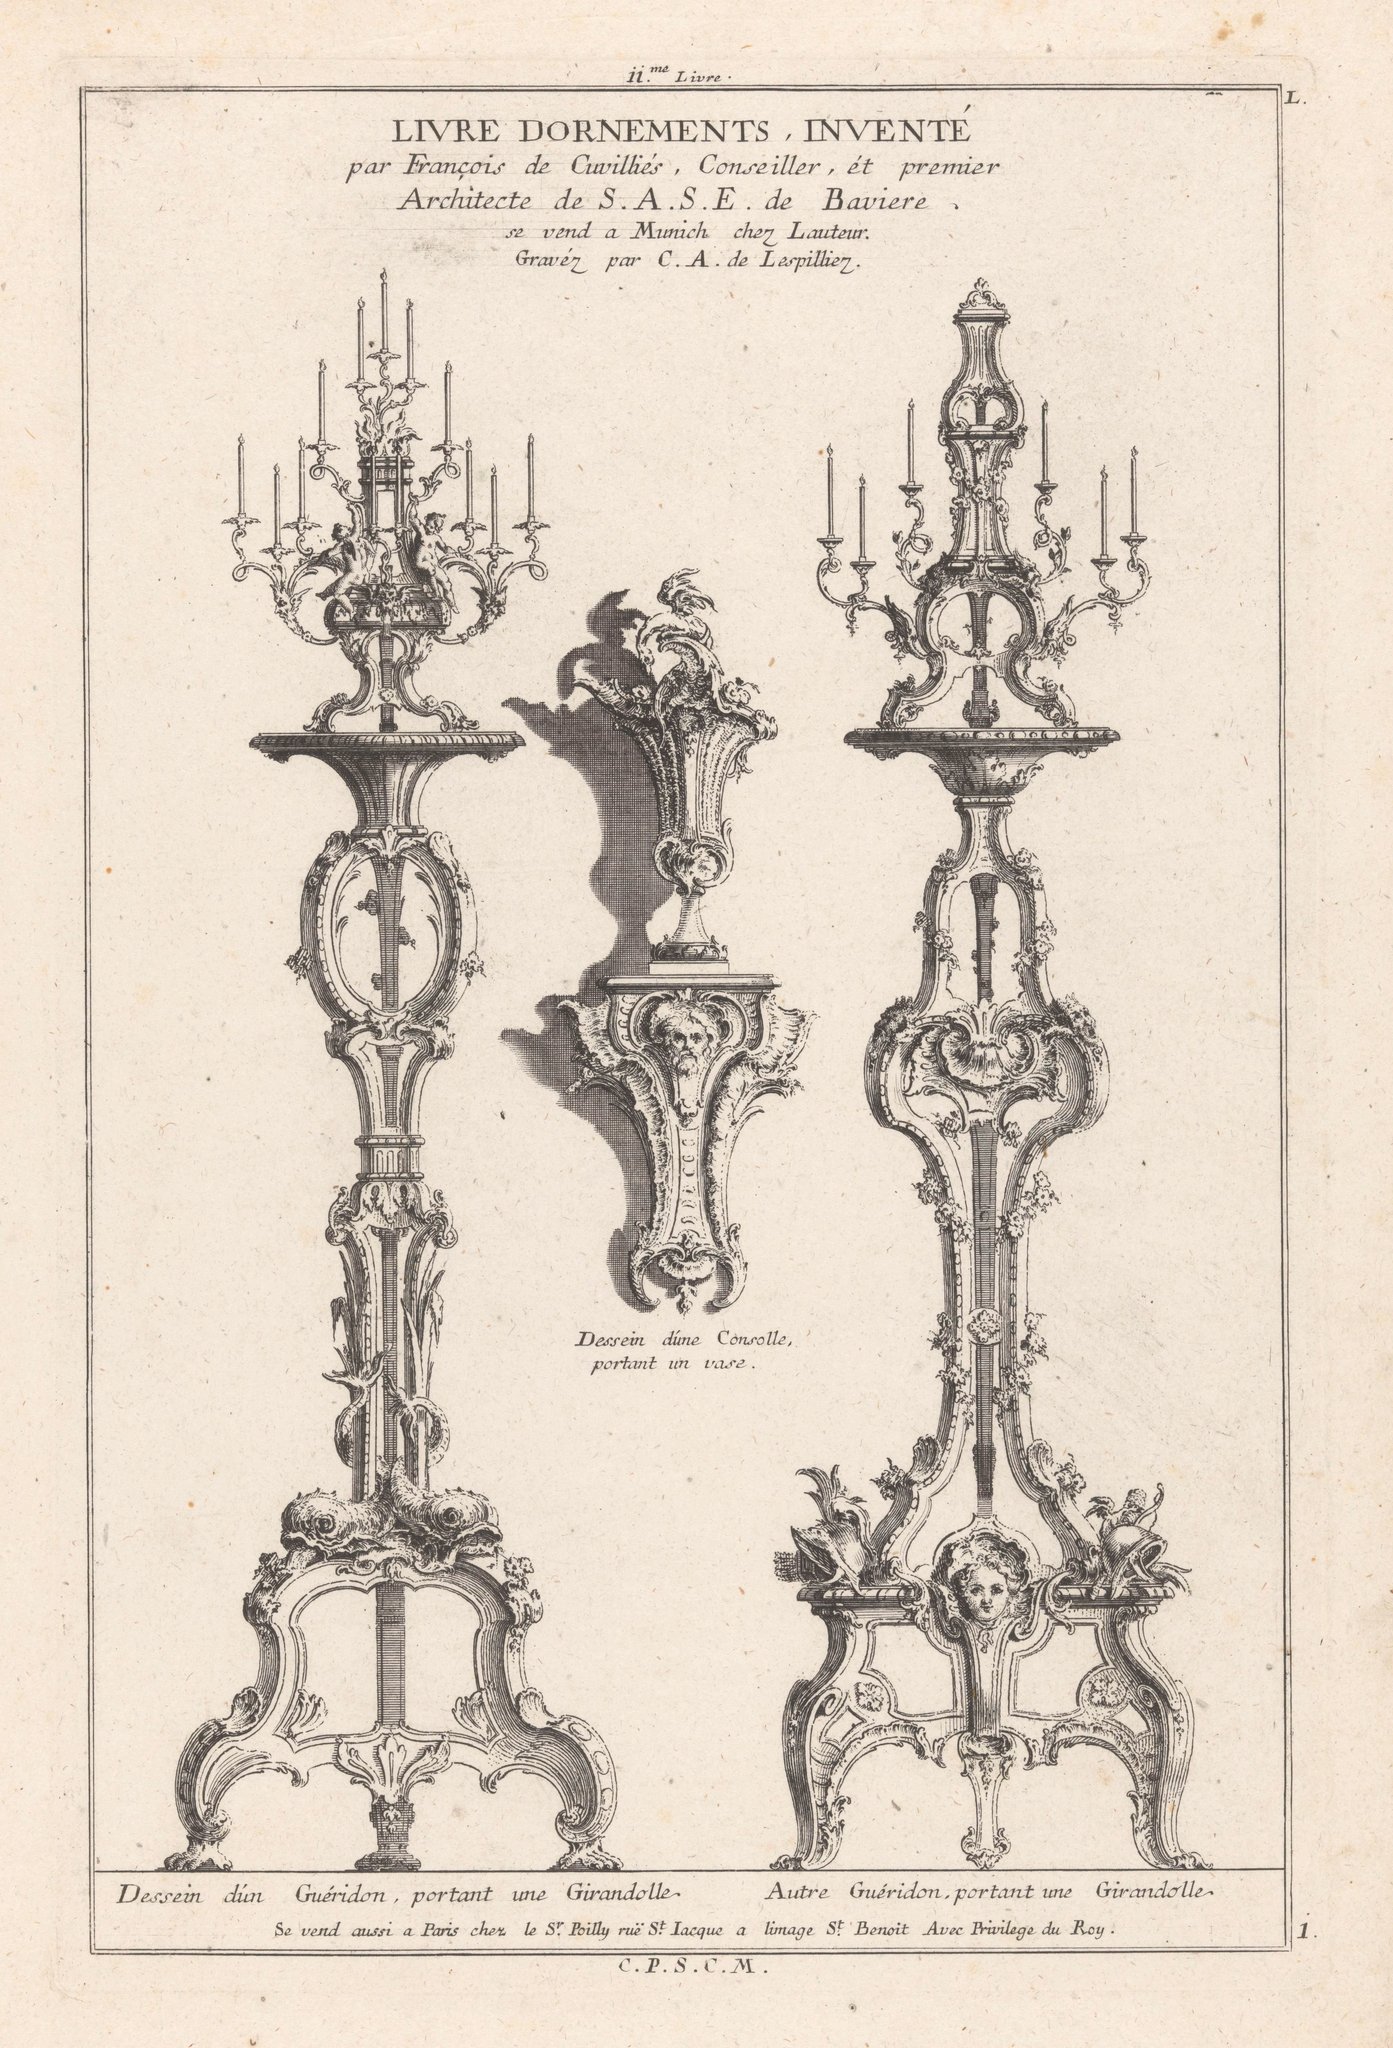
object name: ornament print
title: Gueridons en kandelaars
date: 1745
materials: paper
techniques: etching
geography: munich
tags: chandelier, candelabrum, other architectural details (console), vase ~ ornament, table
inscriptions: collector's mark: Lugt 2228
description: Twee geornamenteerde gueridons met girandoles en een geornamenteerde console met een vaas.